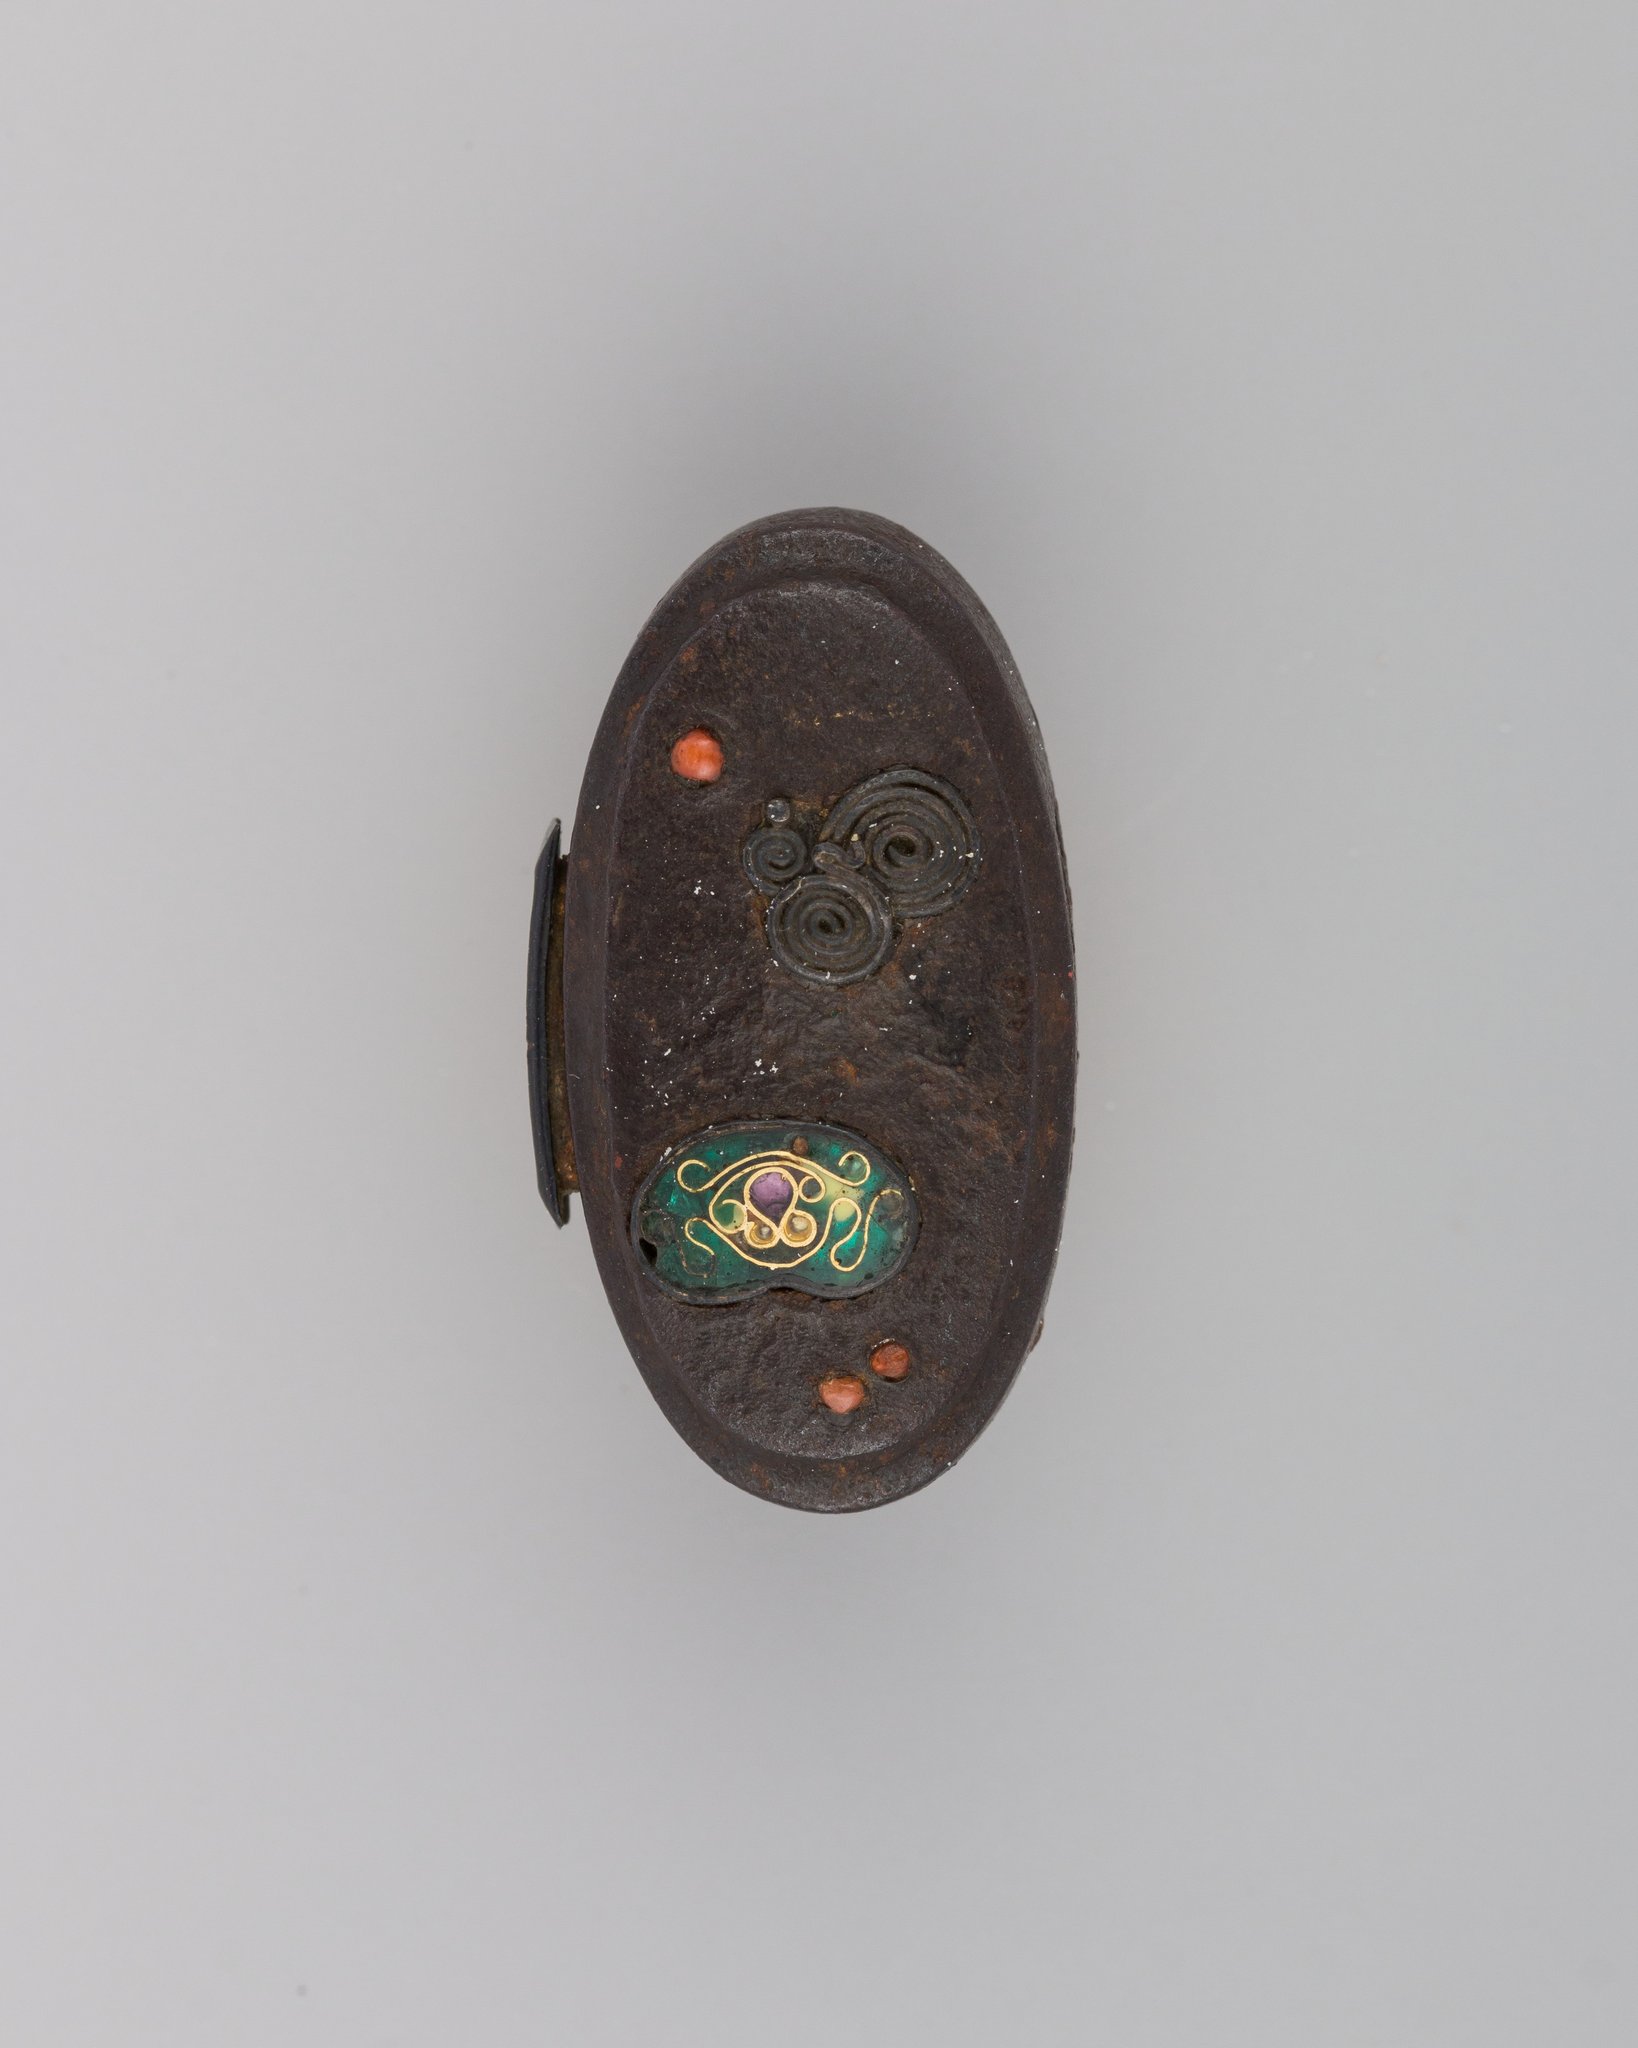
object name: sword pommel kashira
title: Sword Pommel (Kashira)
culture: japanese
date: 1615-1868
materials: enamel, iron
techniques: polychrome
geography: japan